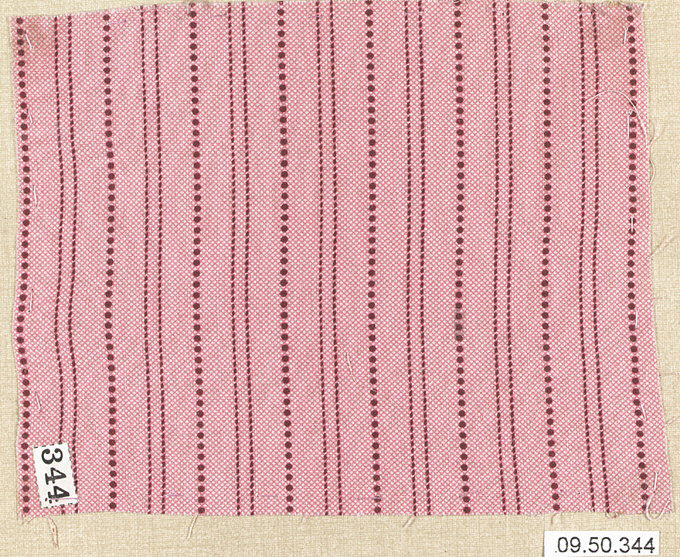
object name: piece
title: Piece (one of 116)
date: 1801-1900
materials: cotton